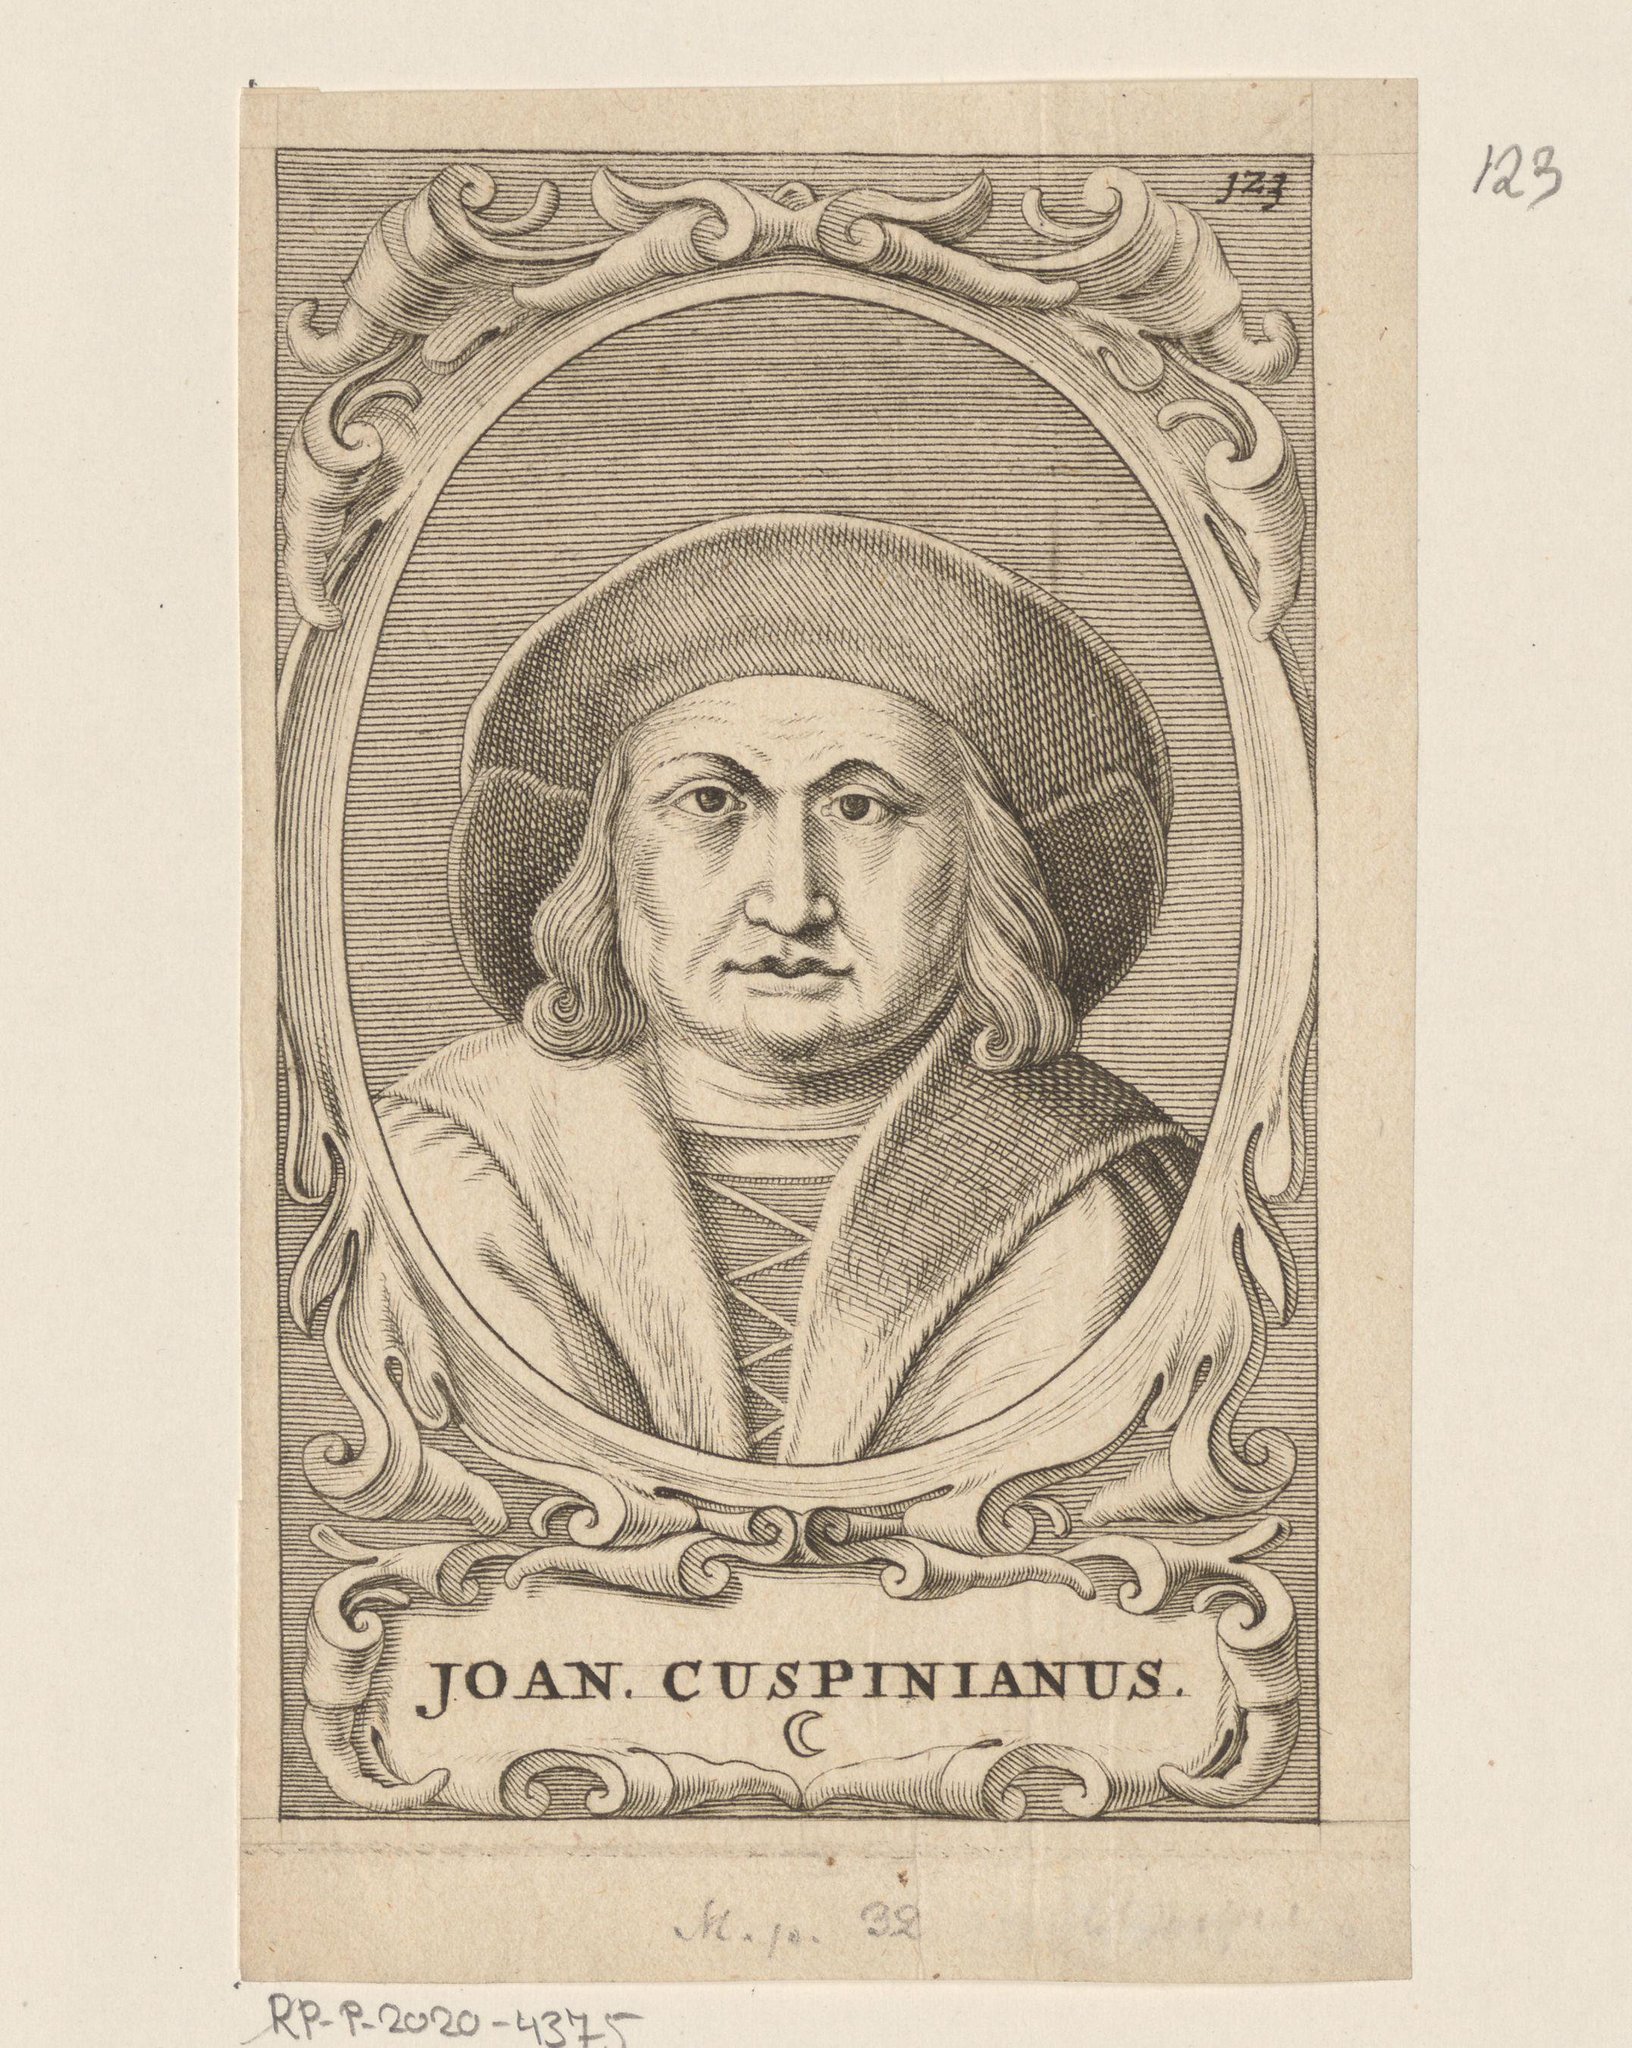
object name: print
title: Portret van Johannes Cuspinian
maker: Anonymous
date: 1600-1699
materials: paper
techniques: engraving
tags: historical persons